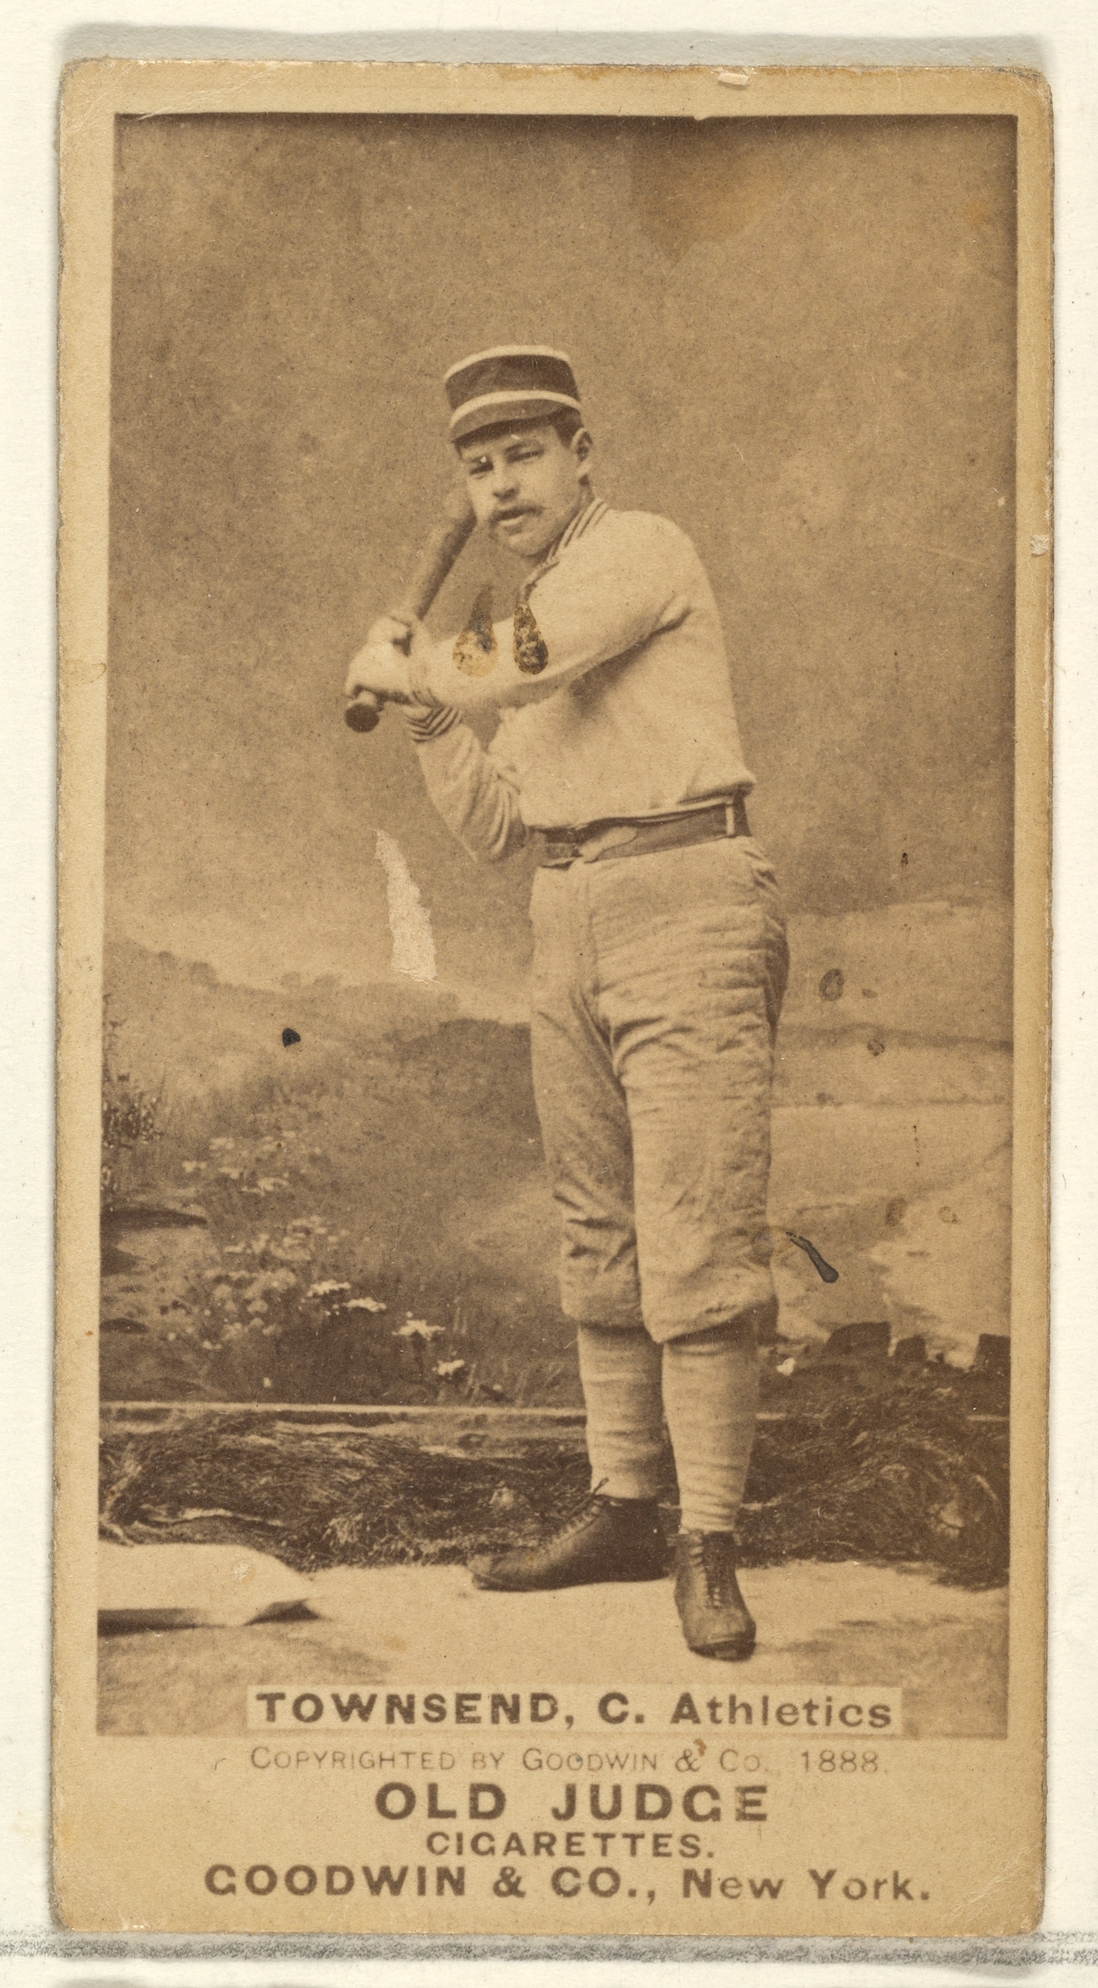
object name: baseball card, photograph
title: Townsend, Catcher, Philadelphia Athletics, from the Old Judge series (N172) for Old Judge Cigarettes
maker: goodwin & company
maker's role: publisher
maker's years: 1850-1950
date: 1888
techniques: albumen silver print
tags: men,portraits,baseball,athletes